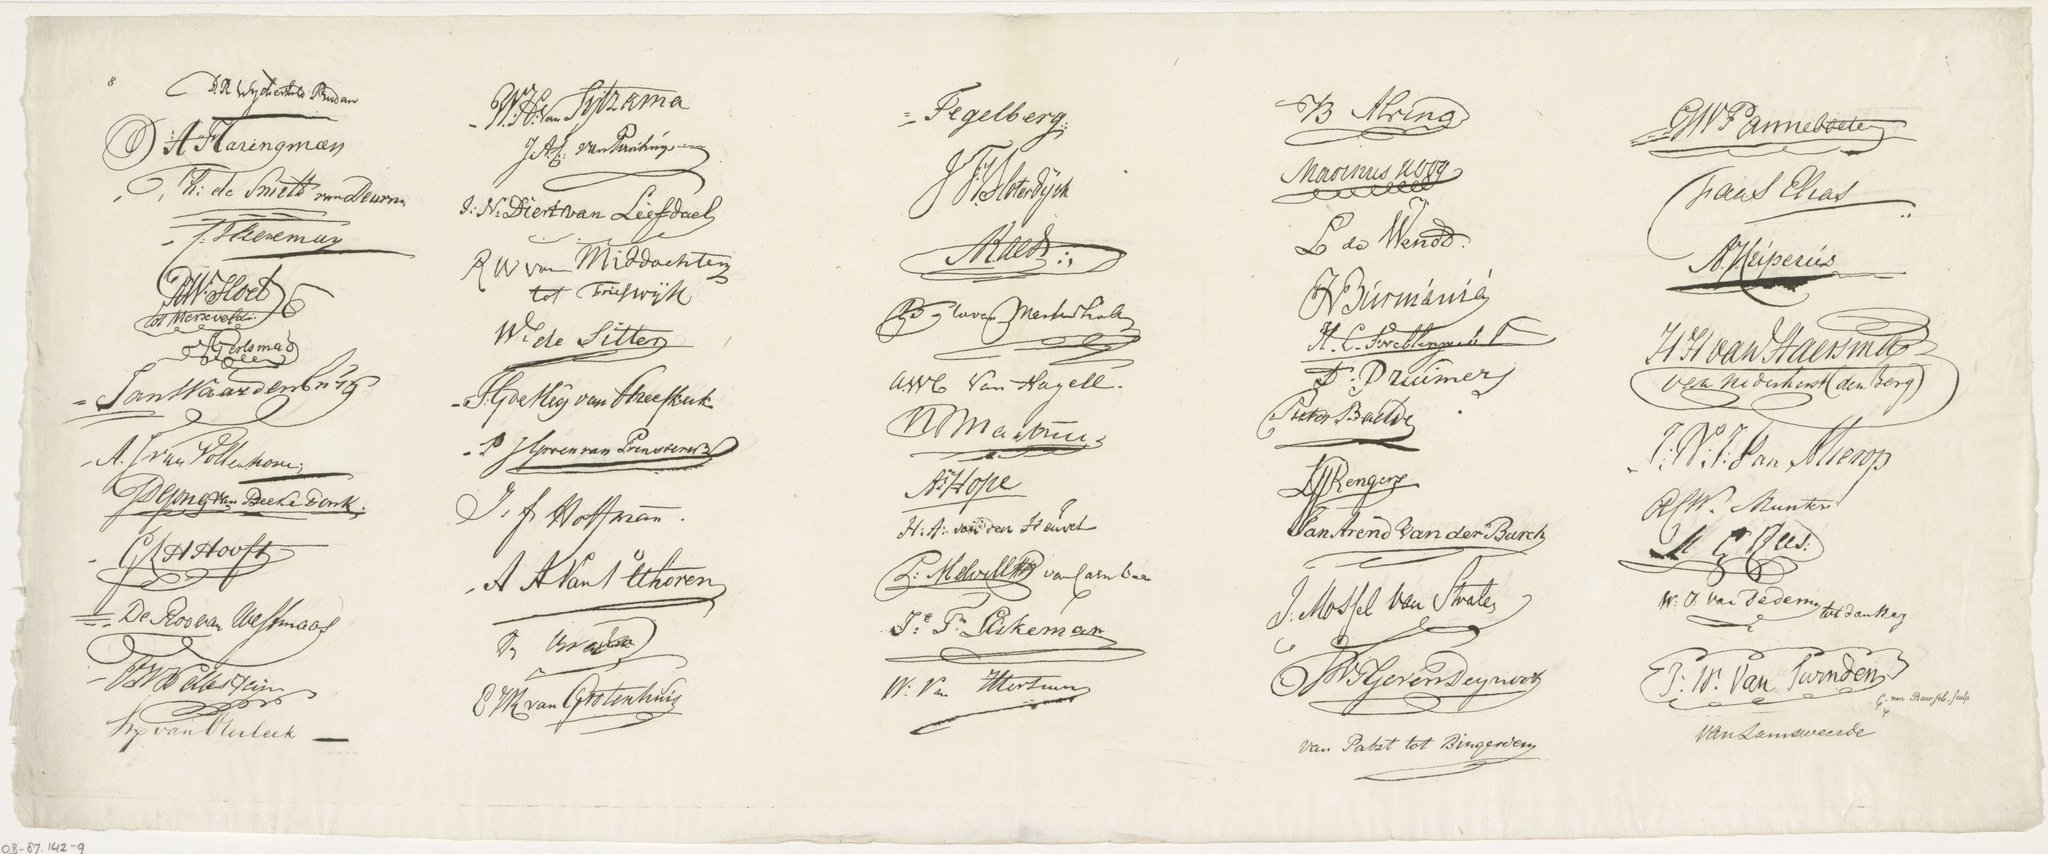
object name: print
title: Blad met handtekeningen van de leden van de Vergadering der Aanzienlijken, 1814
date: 1814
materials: paper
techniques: etching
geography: the hague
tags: the hague, berlin, william i of the netherlands, handwriting, written text, amsterdam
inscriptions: collector's mark: Lugt 2228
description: Blad nr. 8 uit de serie van negen bladen met in facsimile de handtekeningen van de leden van de Vergadering der Aanzienlijken bijeen ter onderhandeling over de nieuwe grondwet, te Amsterdam op 29 maart 1814.